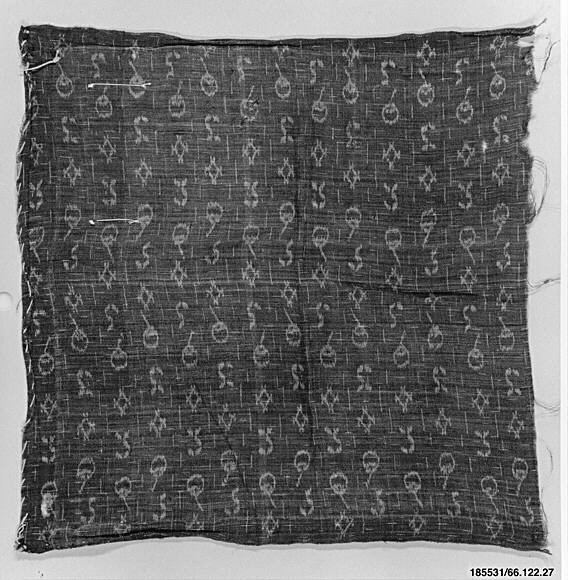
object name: piece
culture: japan, shiga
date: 1801-1900